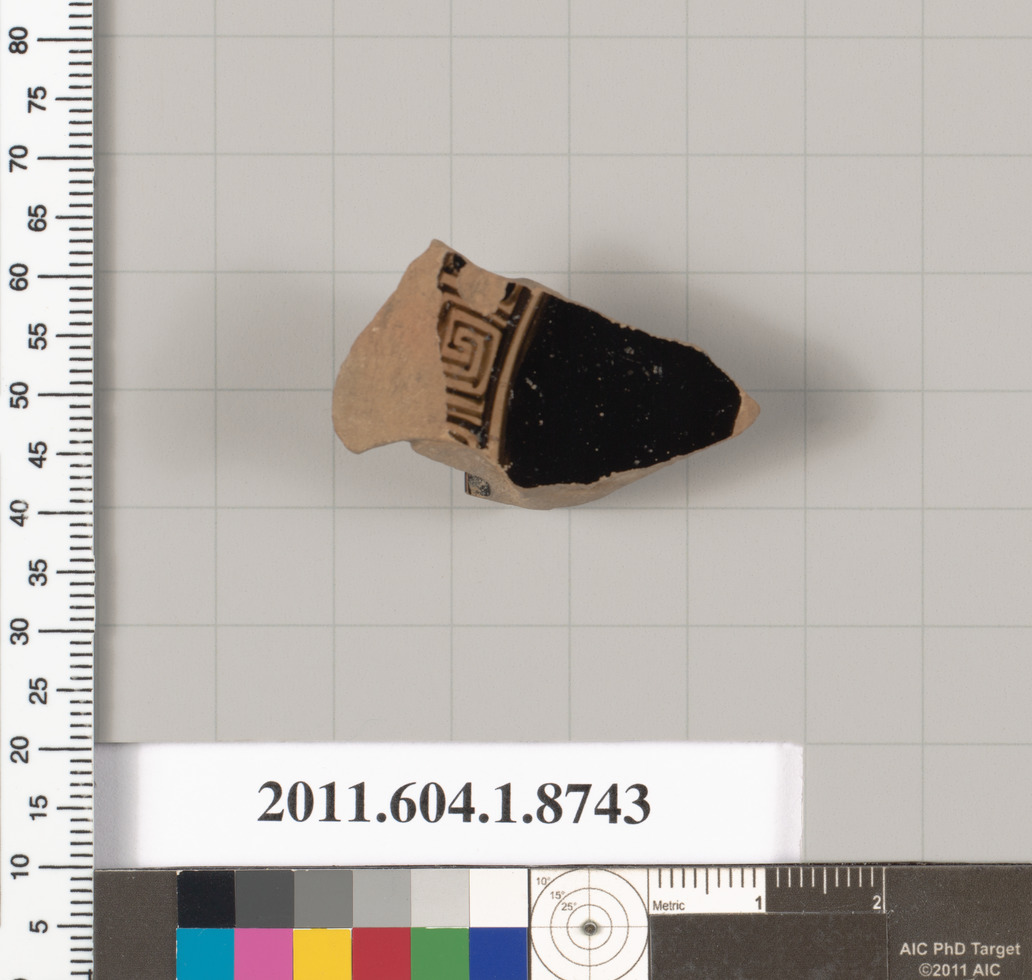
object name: kylix fragment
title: Terracotta fragment of a stemless cup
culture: greek, attic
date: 475-451 BCE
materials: terracotta